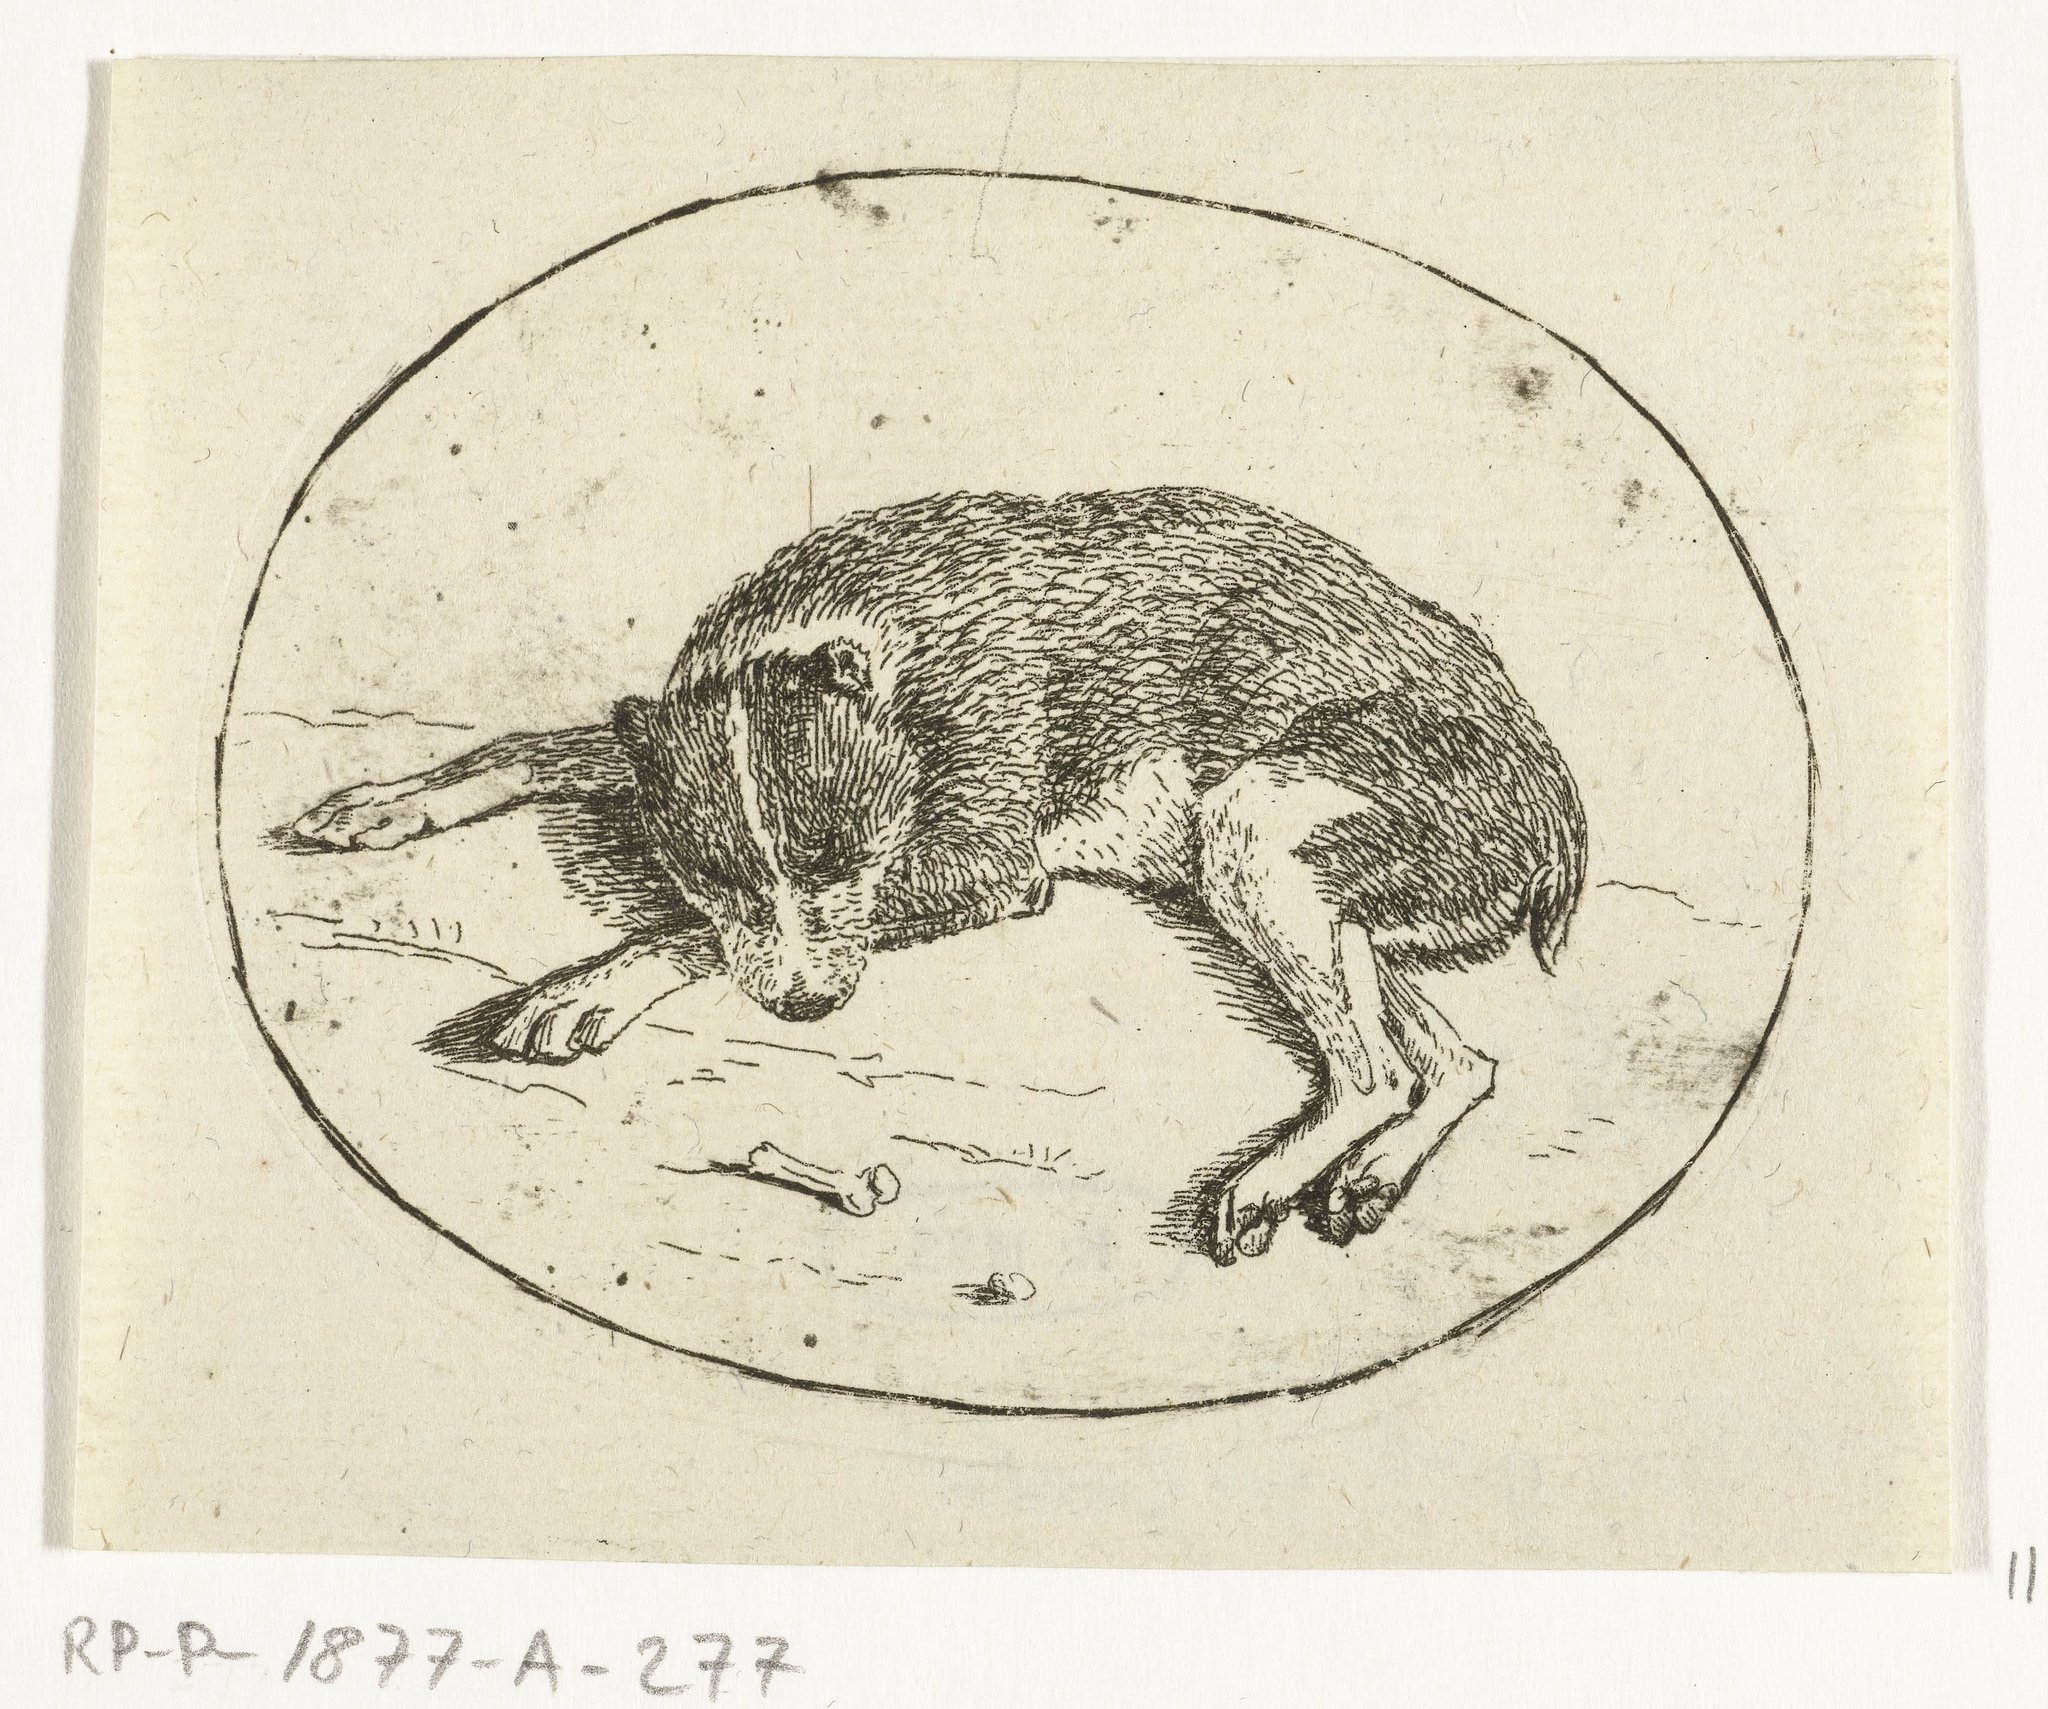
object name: print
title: Liggende hond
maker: anthonie van den bos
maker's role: draughtsman, print maker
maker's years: 1763-1838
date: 1778-1838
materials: paper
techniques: etching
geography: netherlands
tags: dog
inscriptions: collector's mark: Lugt 2228